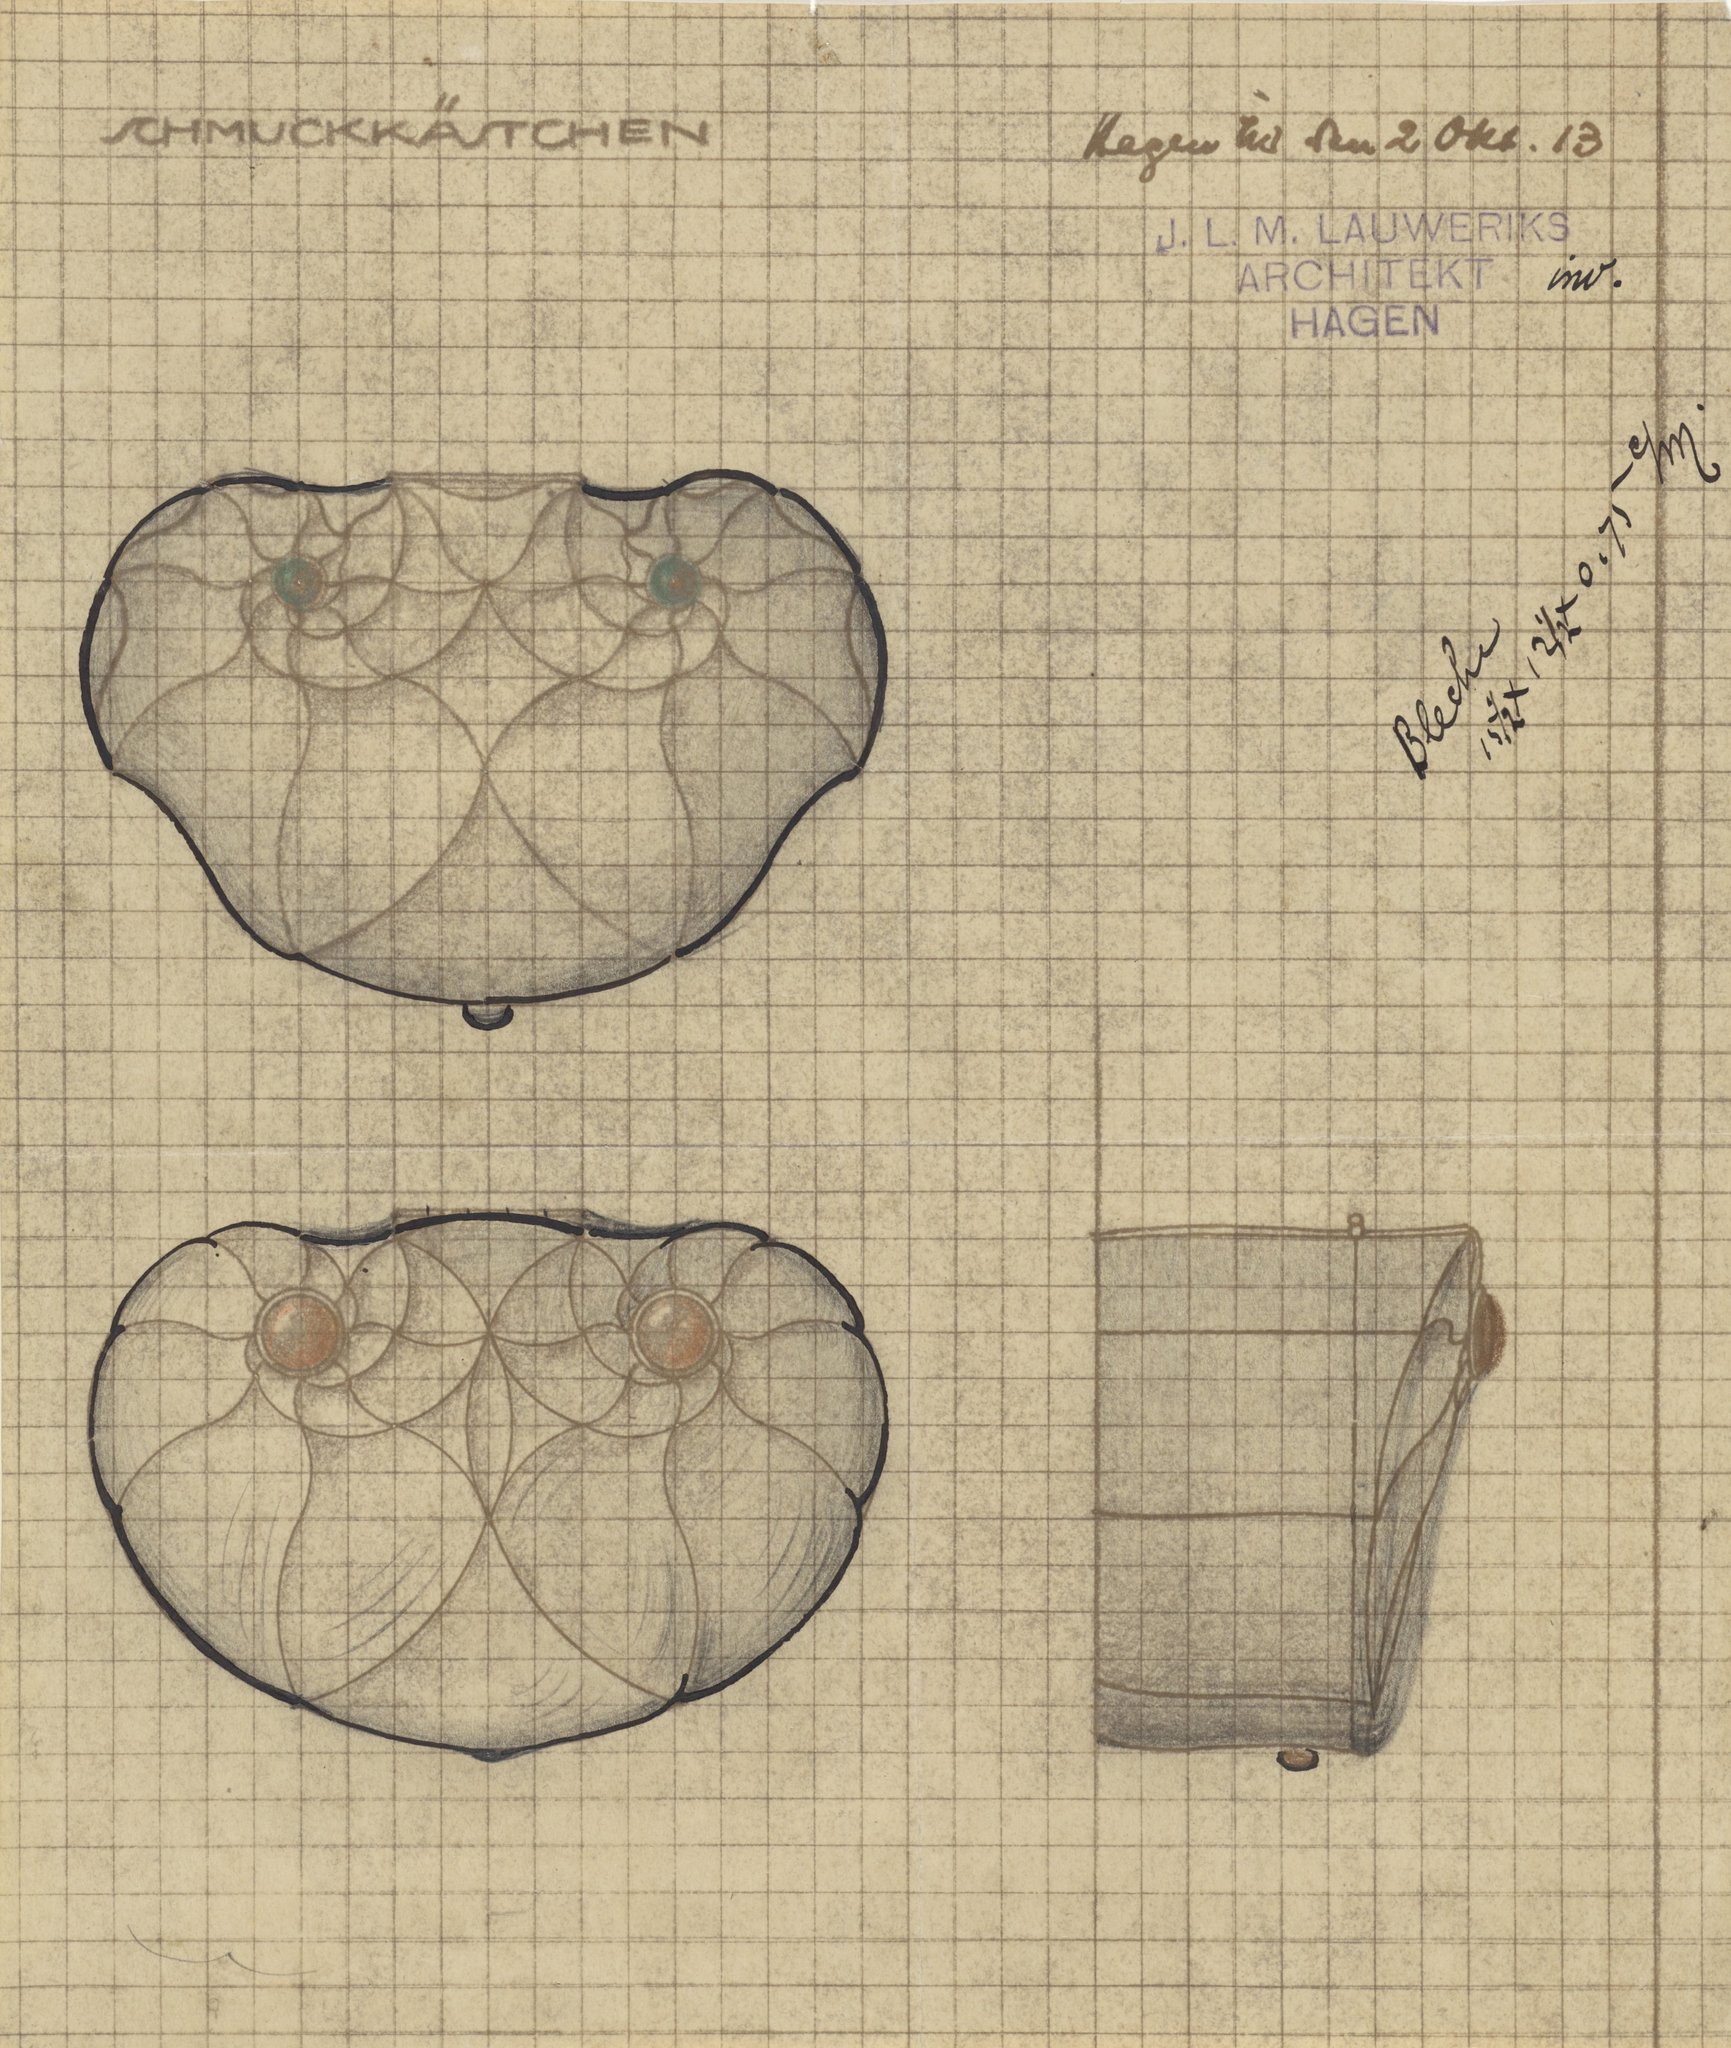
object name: drawing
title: Ontwerp voor een juwelenkistje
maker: mathieu lauweriks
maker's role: designer, draughtsman, print maker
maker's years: 1864-1932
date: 1913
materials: ink, paper, pencil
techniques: blueprint, pen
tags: jewel-box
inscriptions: date: ‘2 Okt. 13’